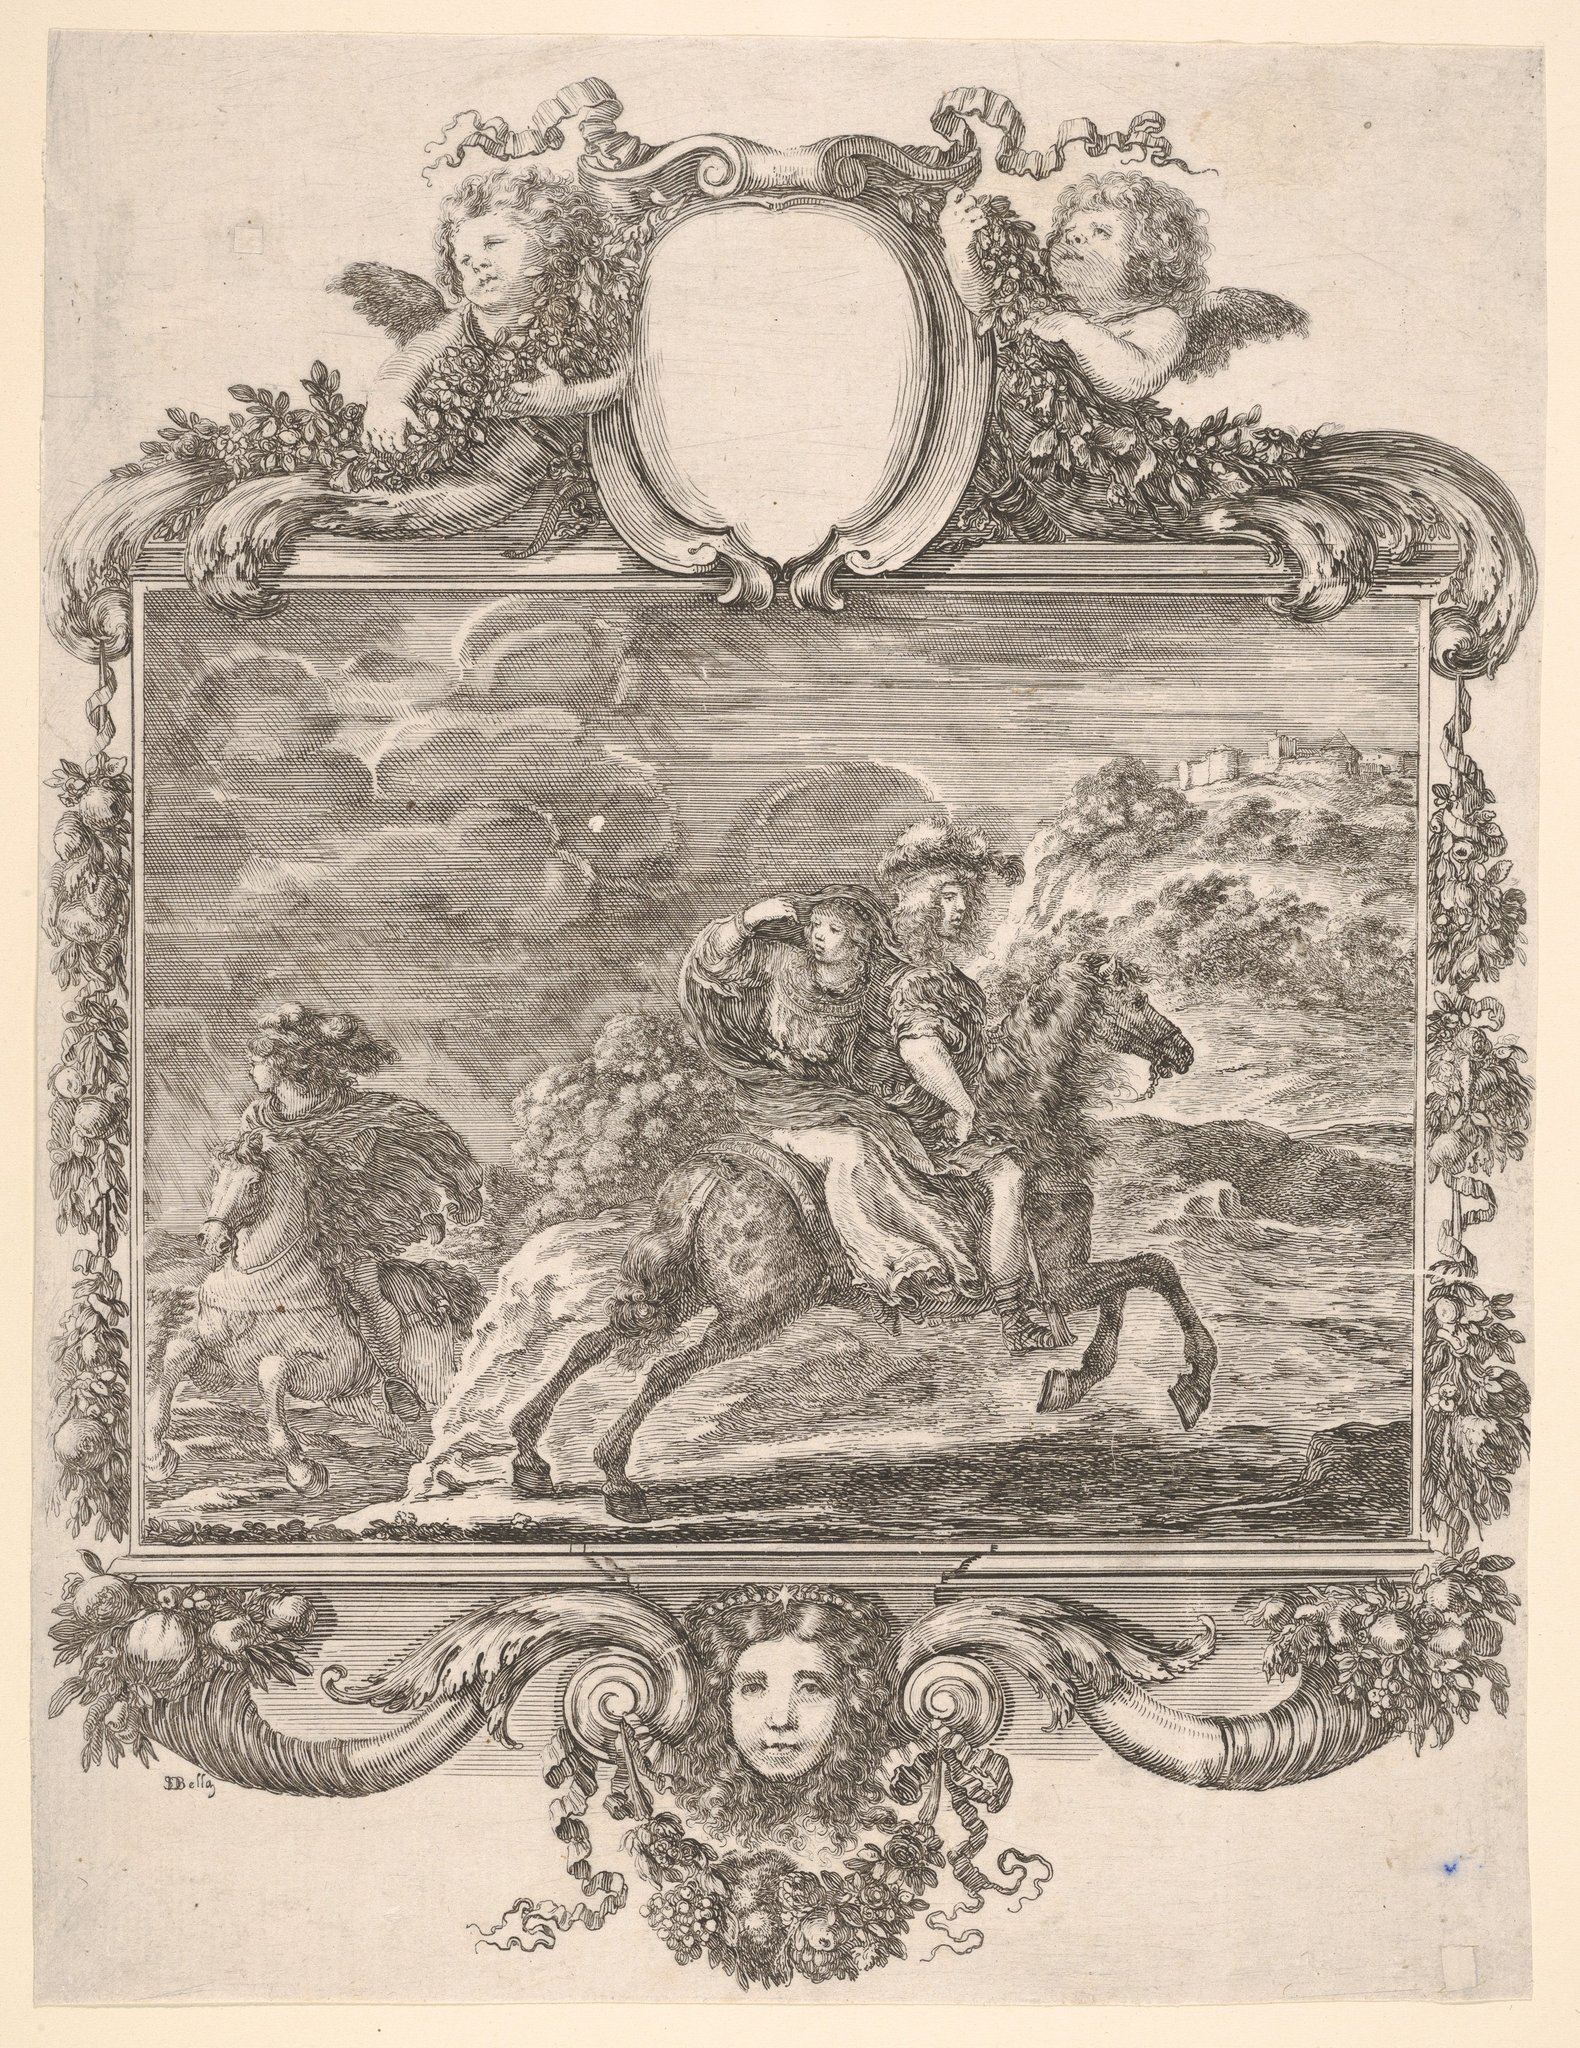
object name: print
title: A horseman and a lady riding side saddle, galloping towards the right, another horseman follows, in an elaborate frame decorated with a mask of a young woman, cherubs, and fruit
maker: stefano della bella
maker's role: artist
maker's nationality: italian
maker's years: 1610-1664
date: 1652-1657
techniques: etching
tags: masks,men,women,horses